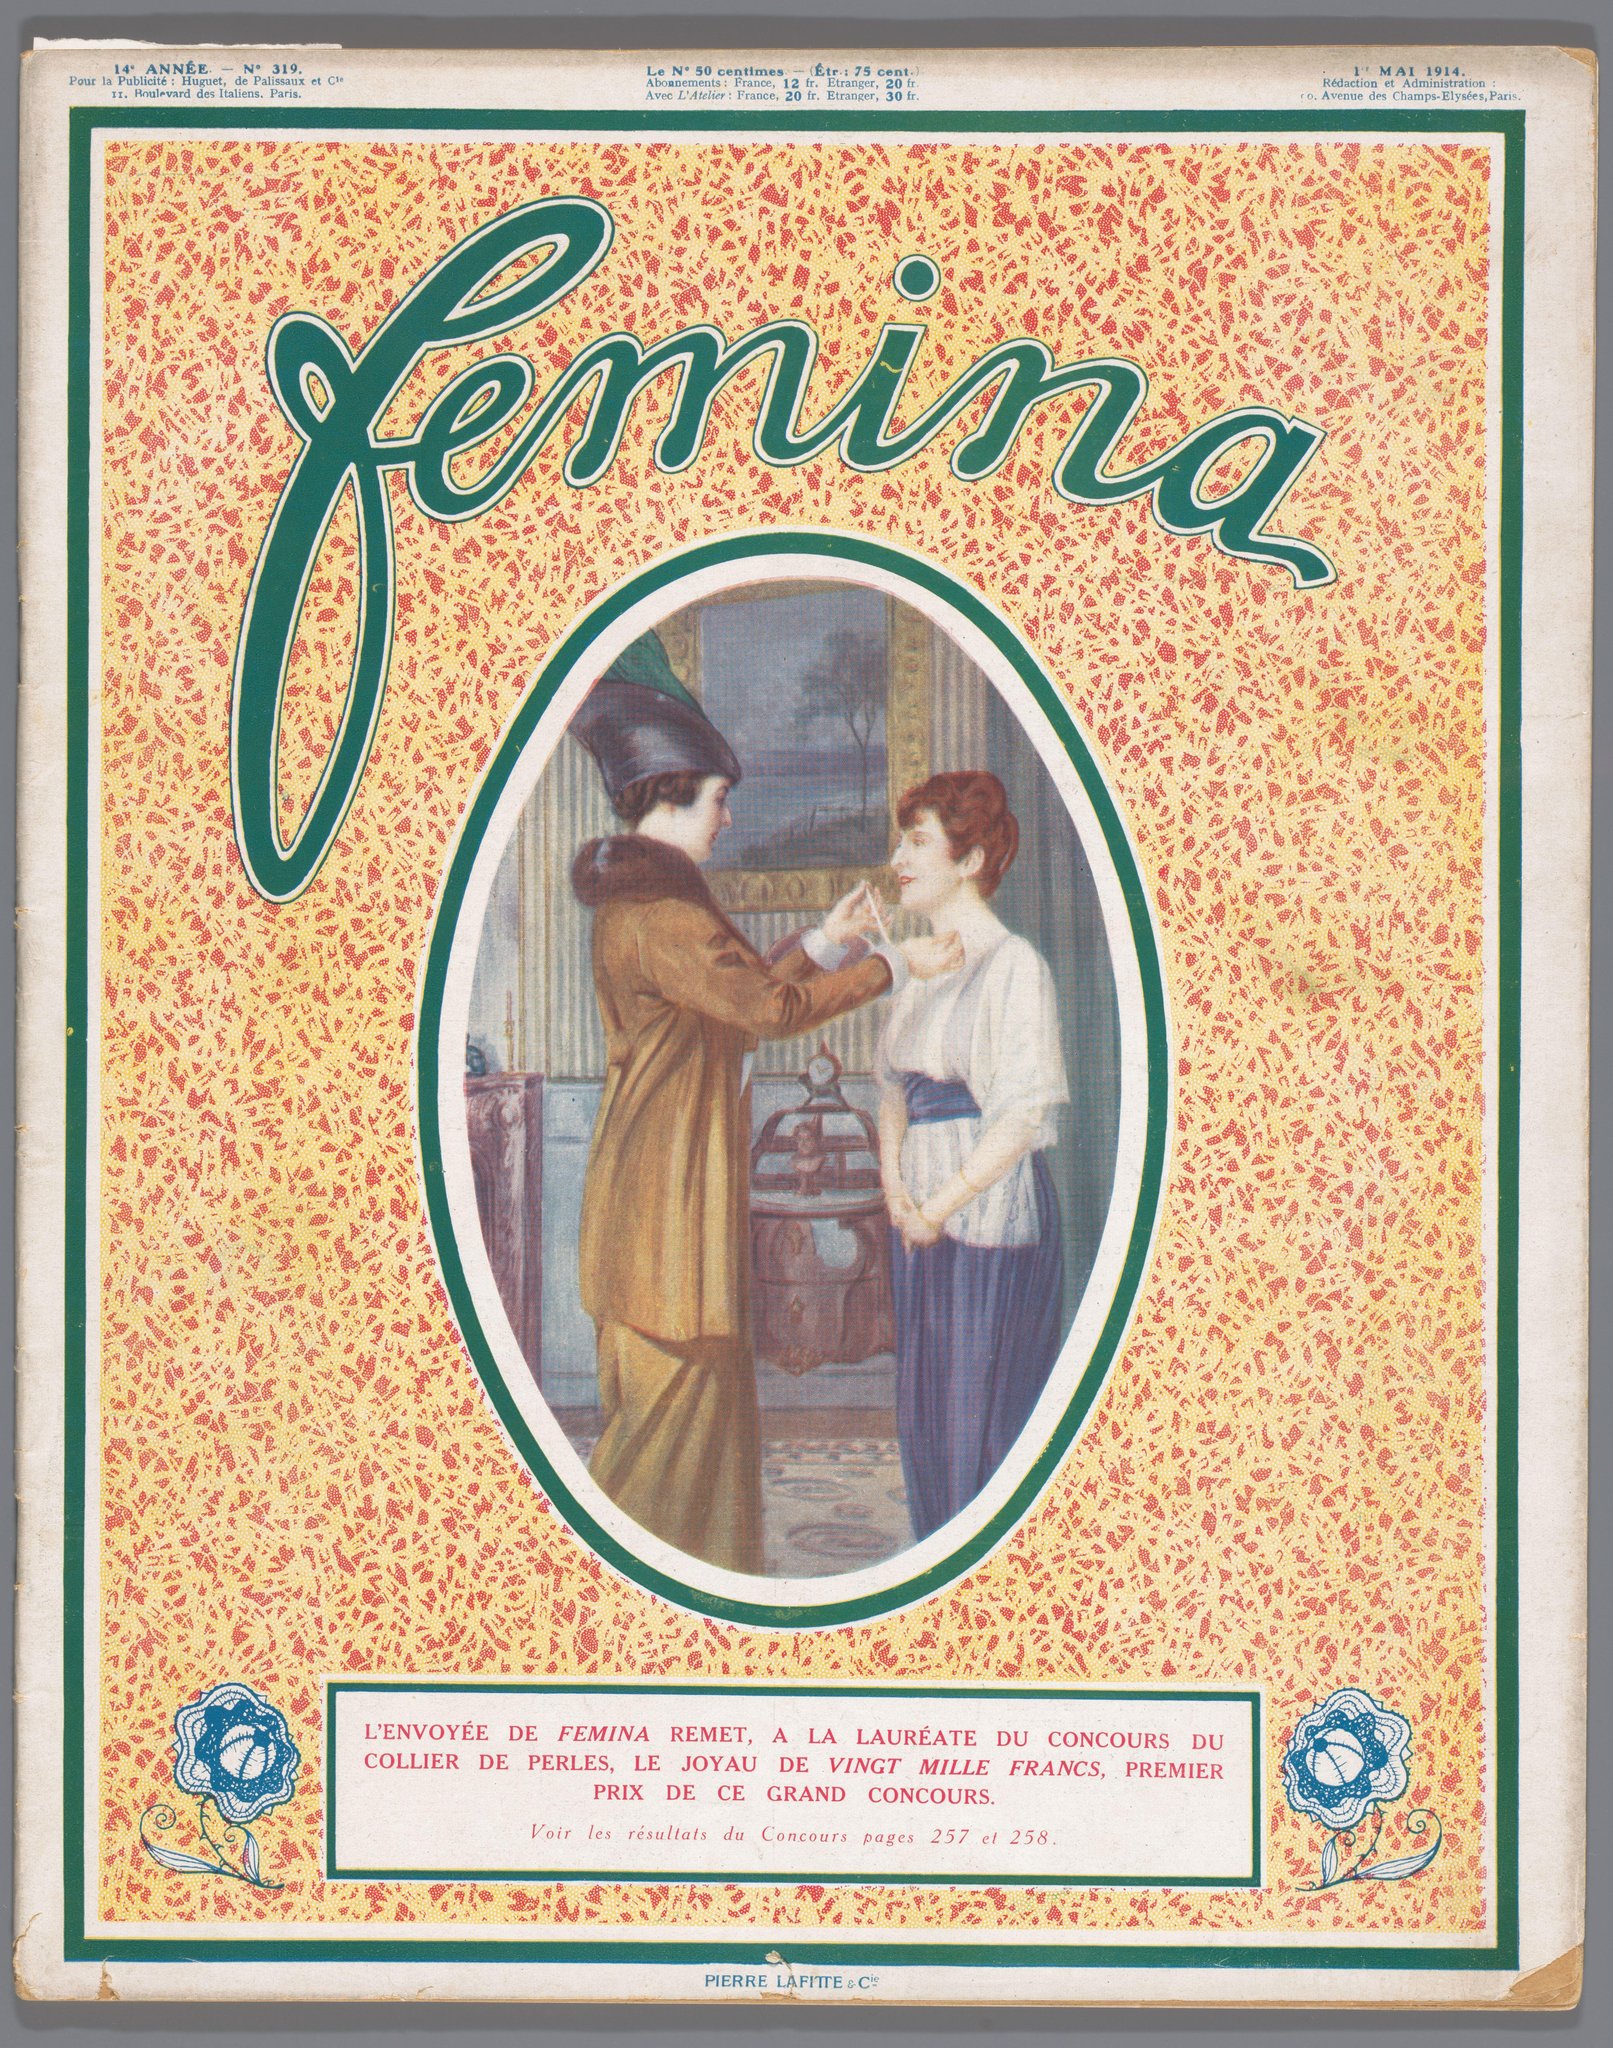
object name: magazine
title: Femina, 1 Mai 1914, 14e Année, nr. 19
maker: pierre laffitte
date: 1914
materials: paper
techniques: photography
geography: paris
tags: fashion plates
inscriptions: title: ‘FEMINA’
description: Modetijdschrift Femina. 14e Année, nr. 19: 1 Mai 1914. Cover: in ovaal de voorstelling van een dame met hoed die een vrouw een ketting omdoet.